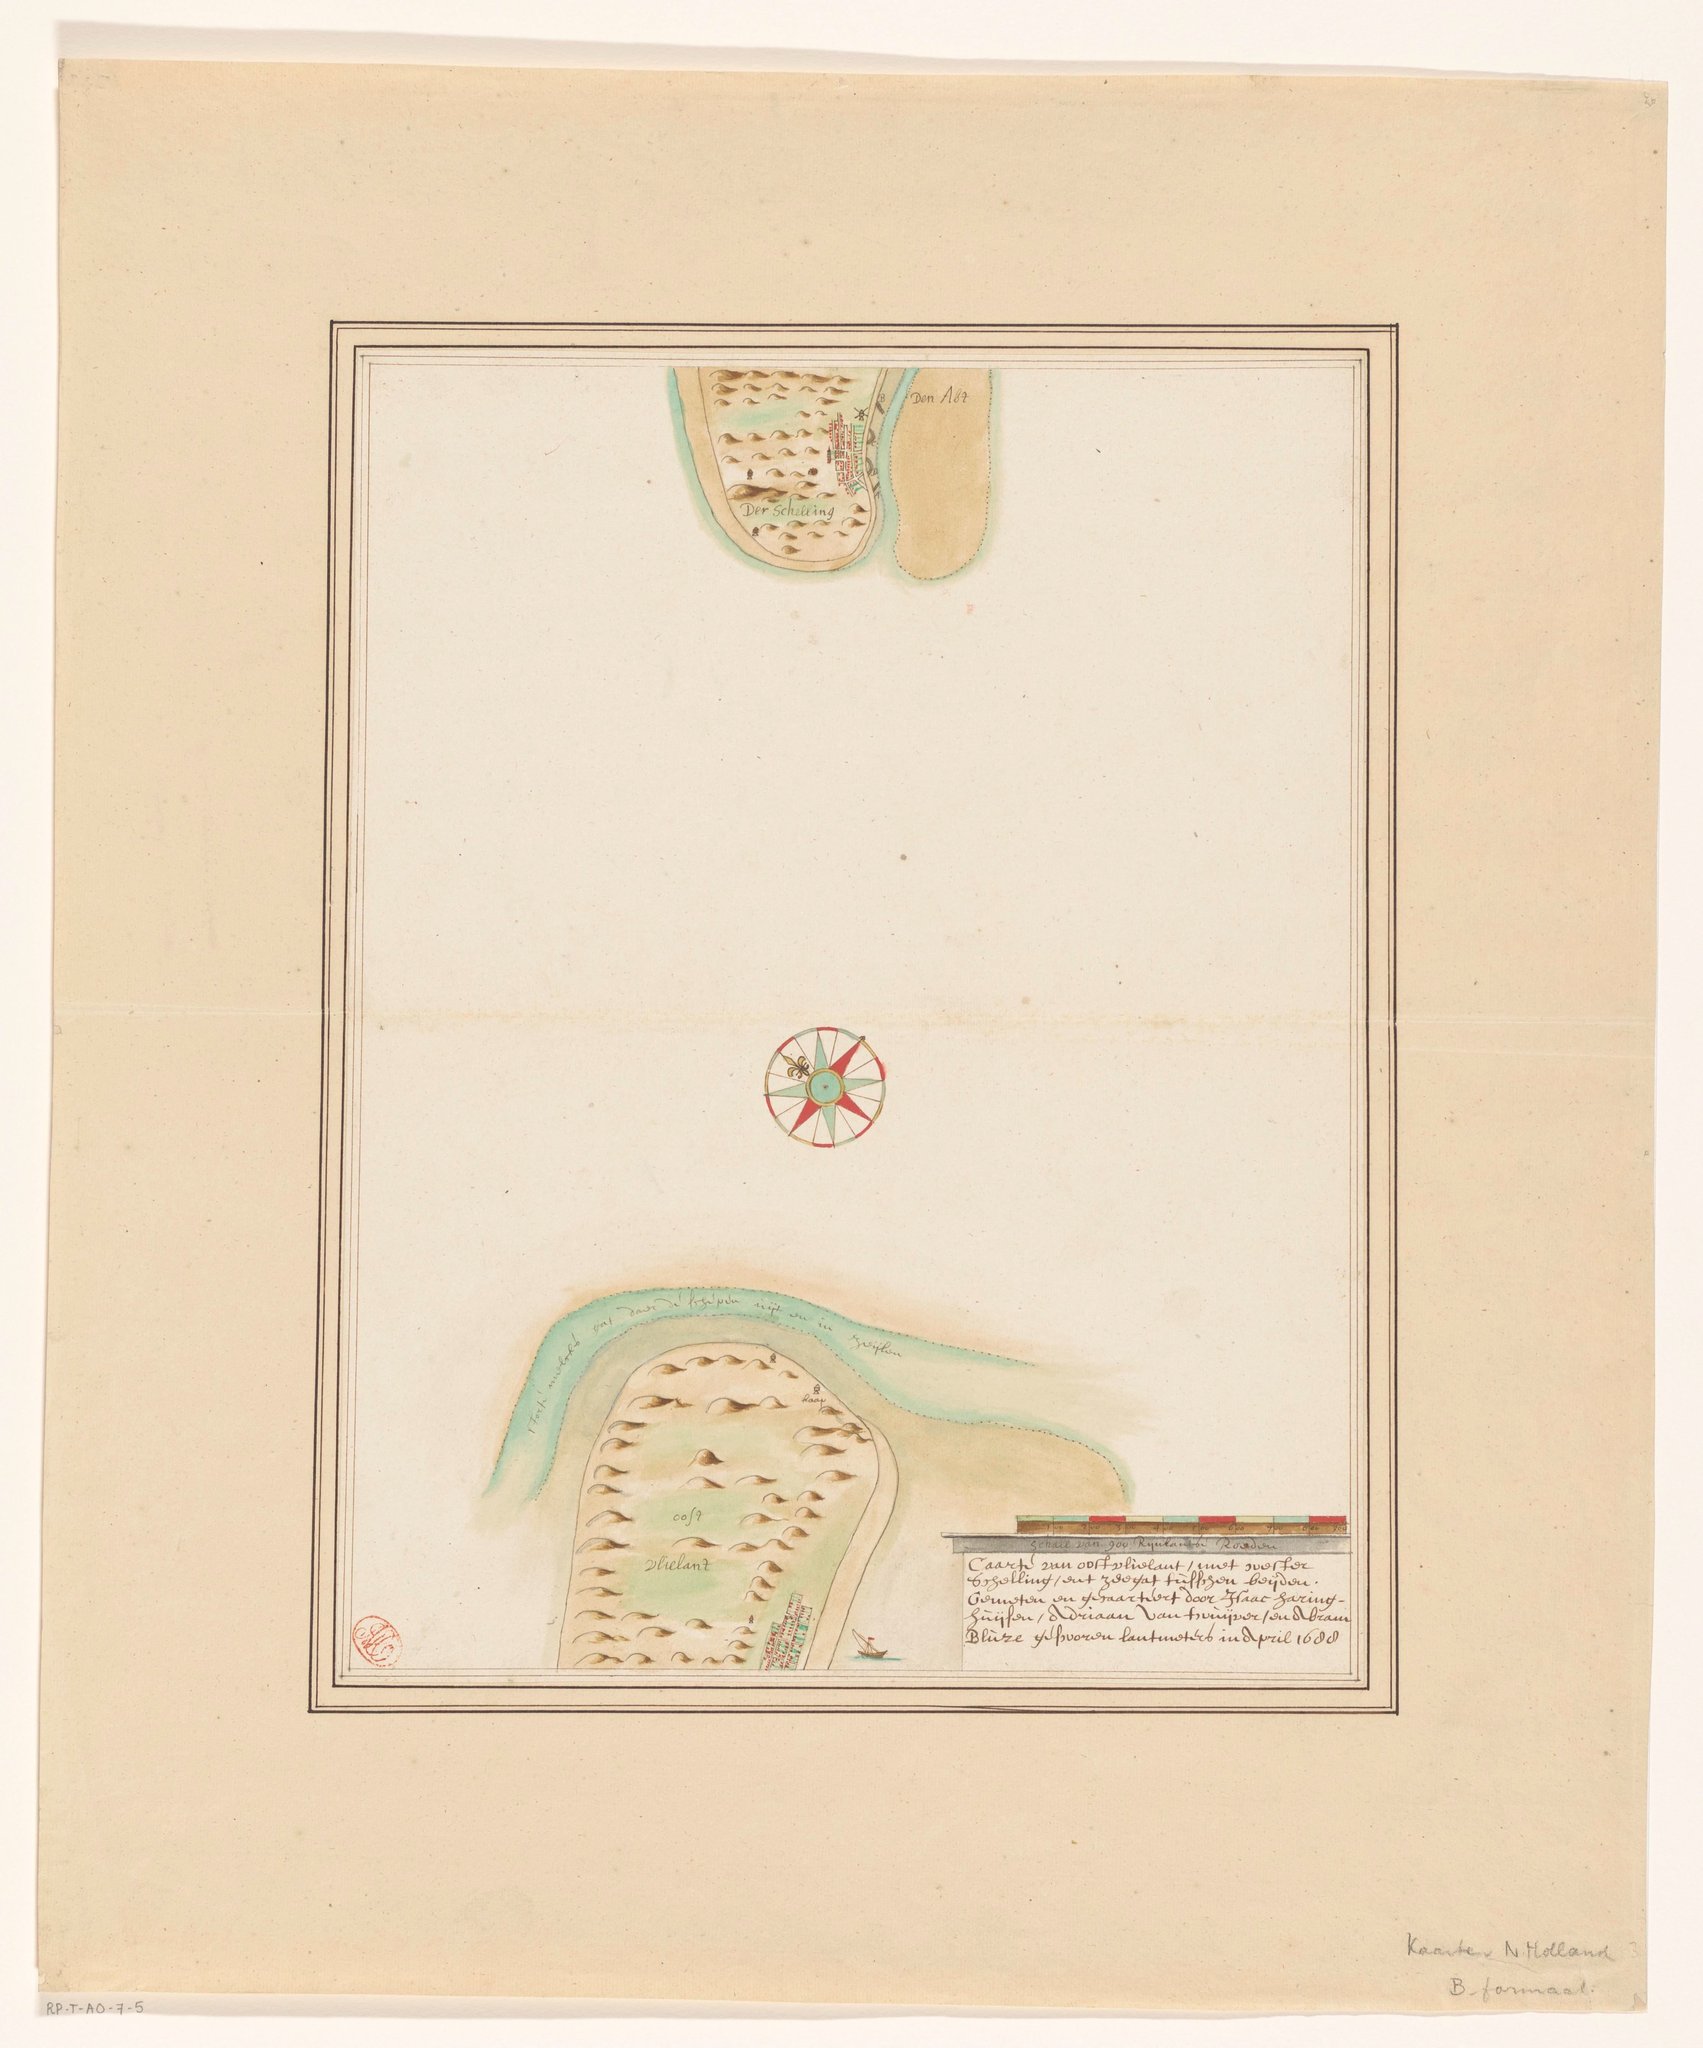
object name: map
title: Caarte van Oostvlielant, met wester Schelling, ent zeegat tusschen beijden. Gemeten en gecaarteert door Isaac Haringhuijsen, Adriaan van Twuijver, en Abram Bluze gesworen lantmeters in april 1688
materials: ink, paper, watercolor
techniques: brush, pen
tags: maps of separate countries or regions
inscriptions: collector's mark: Lugt 195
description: Rechtsonder de titel met daarboven een schaalstok Schale van 900 Rijnlantse roeden.